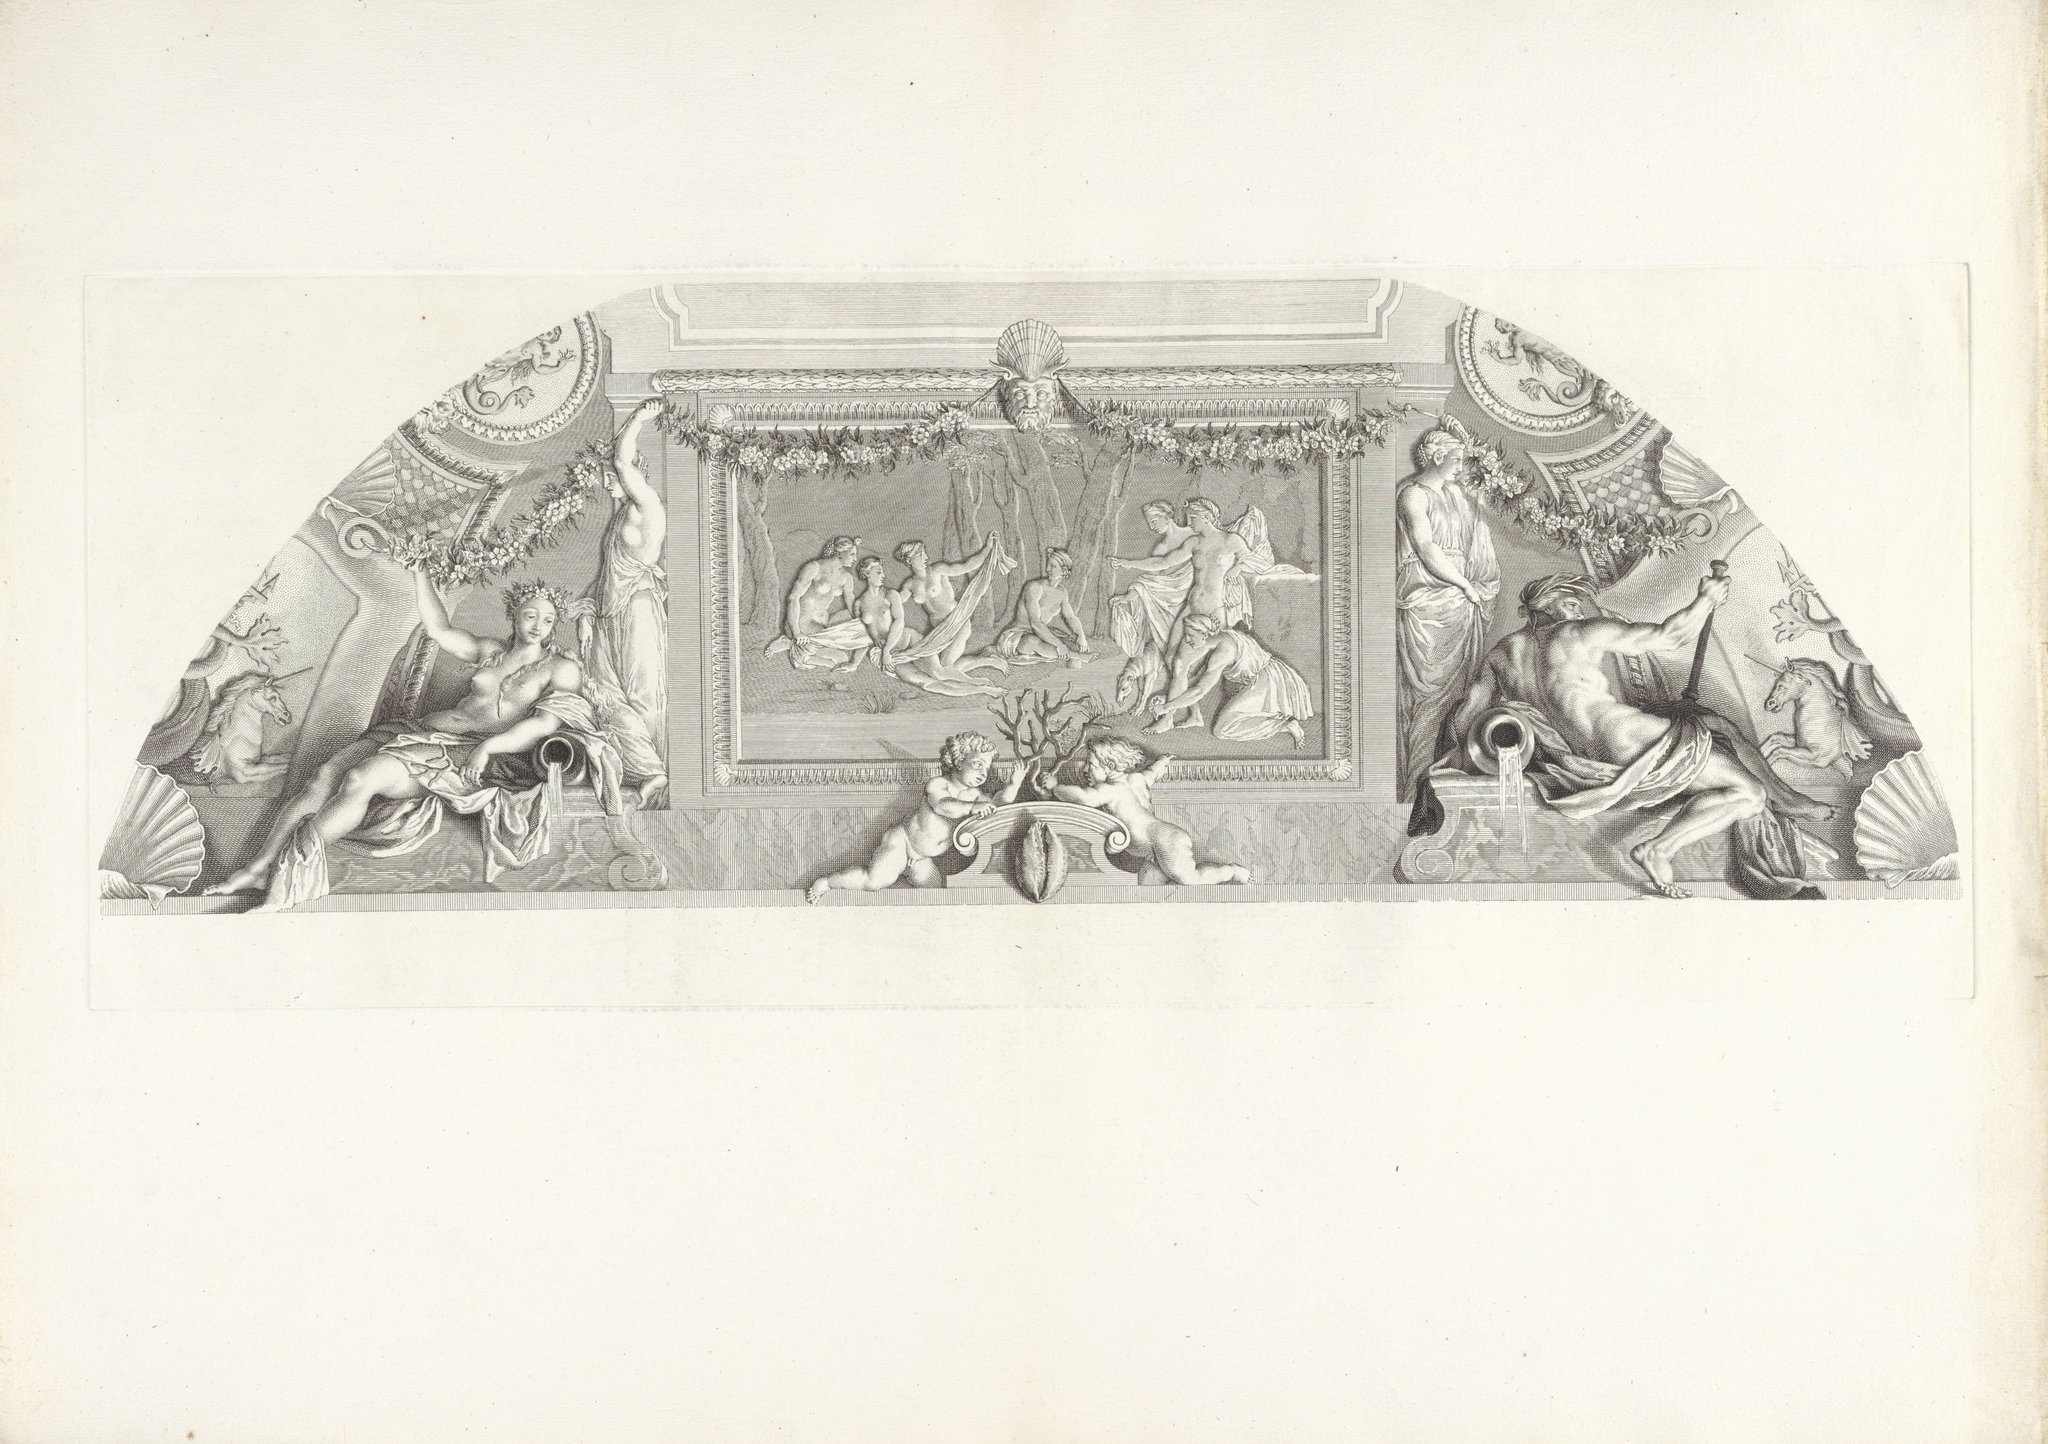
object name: print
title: Diana en Callisto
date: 1740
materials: paper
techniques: engraving, etching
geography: paris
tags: coelenterata: coral, diana with her nymphs discovers the pregnancy of callisto, ornament ~ festoon, garland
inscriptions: collector's mark: Lugt 2228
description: Grisaille, met de voorstelling van de godin Diana, die de zwangerschap van de nimf Callisto ontdekt, in de hoek van het plafond van de Chambre des Bains in het Hôtel Lambert. De voorstelling van Diana en callisto wordt geflankeerd door een stroomgodin en een stroomgod, ieder met een waterkan. Midden onder twee putti met koraal. Prent maakt deel uit van een serie prenten naar schilderijen in het Hôtel Lambert te Parijs.